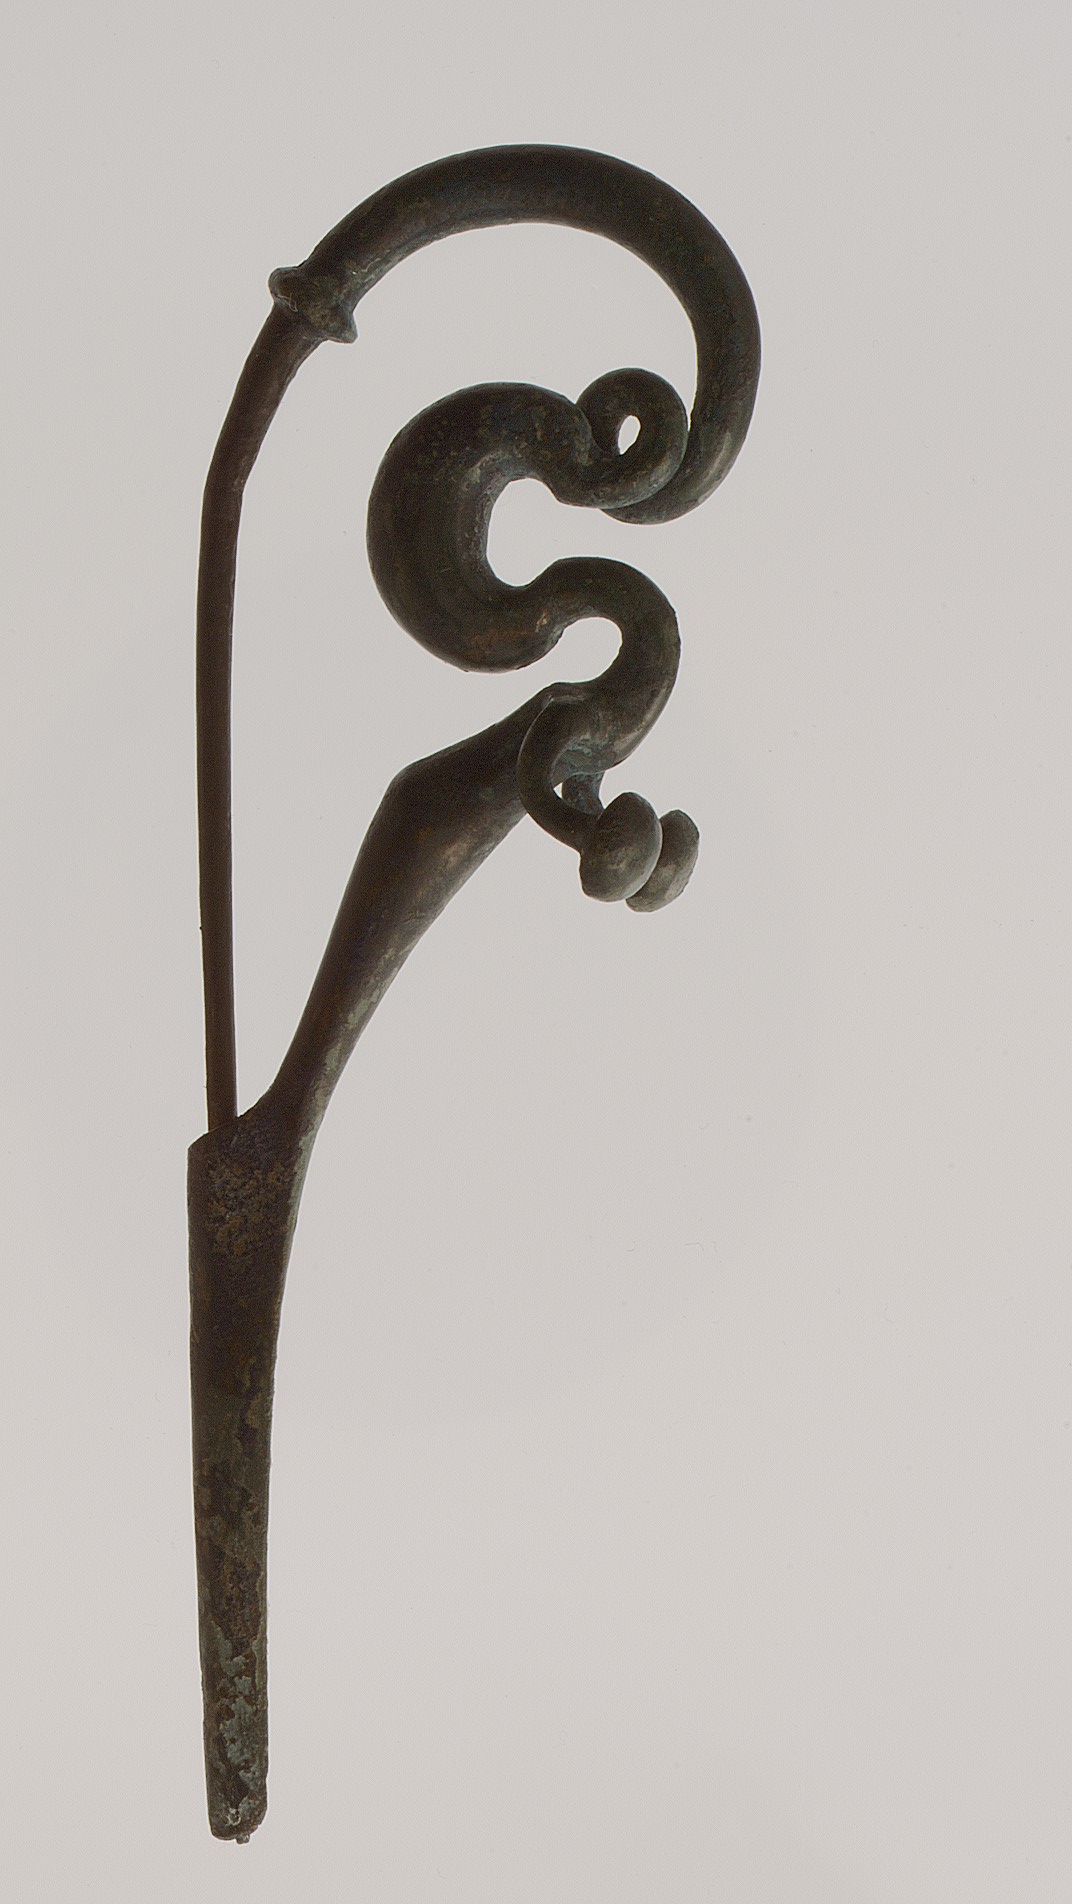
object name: brooch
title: S-Shaped Brooch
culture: celtic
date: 600-501 BCE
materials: bronze